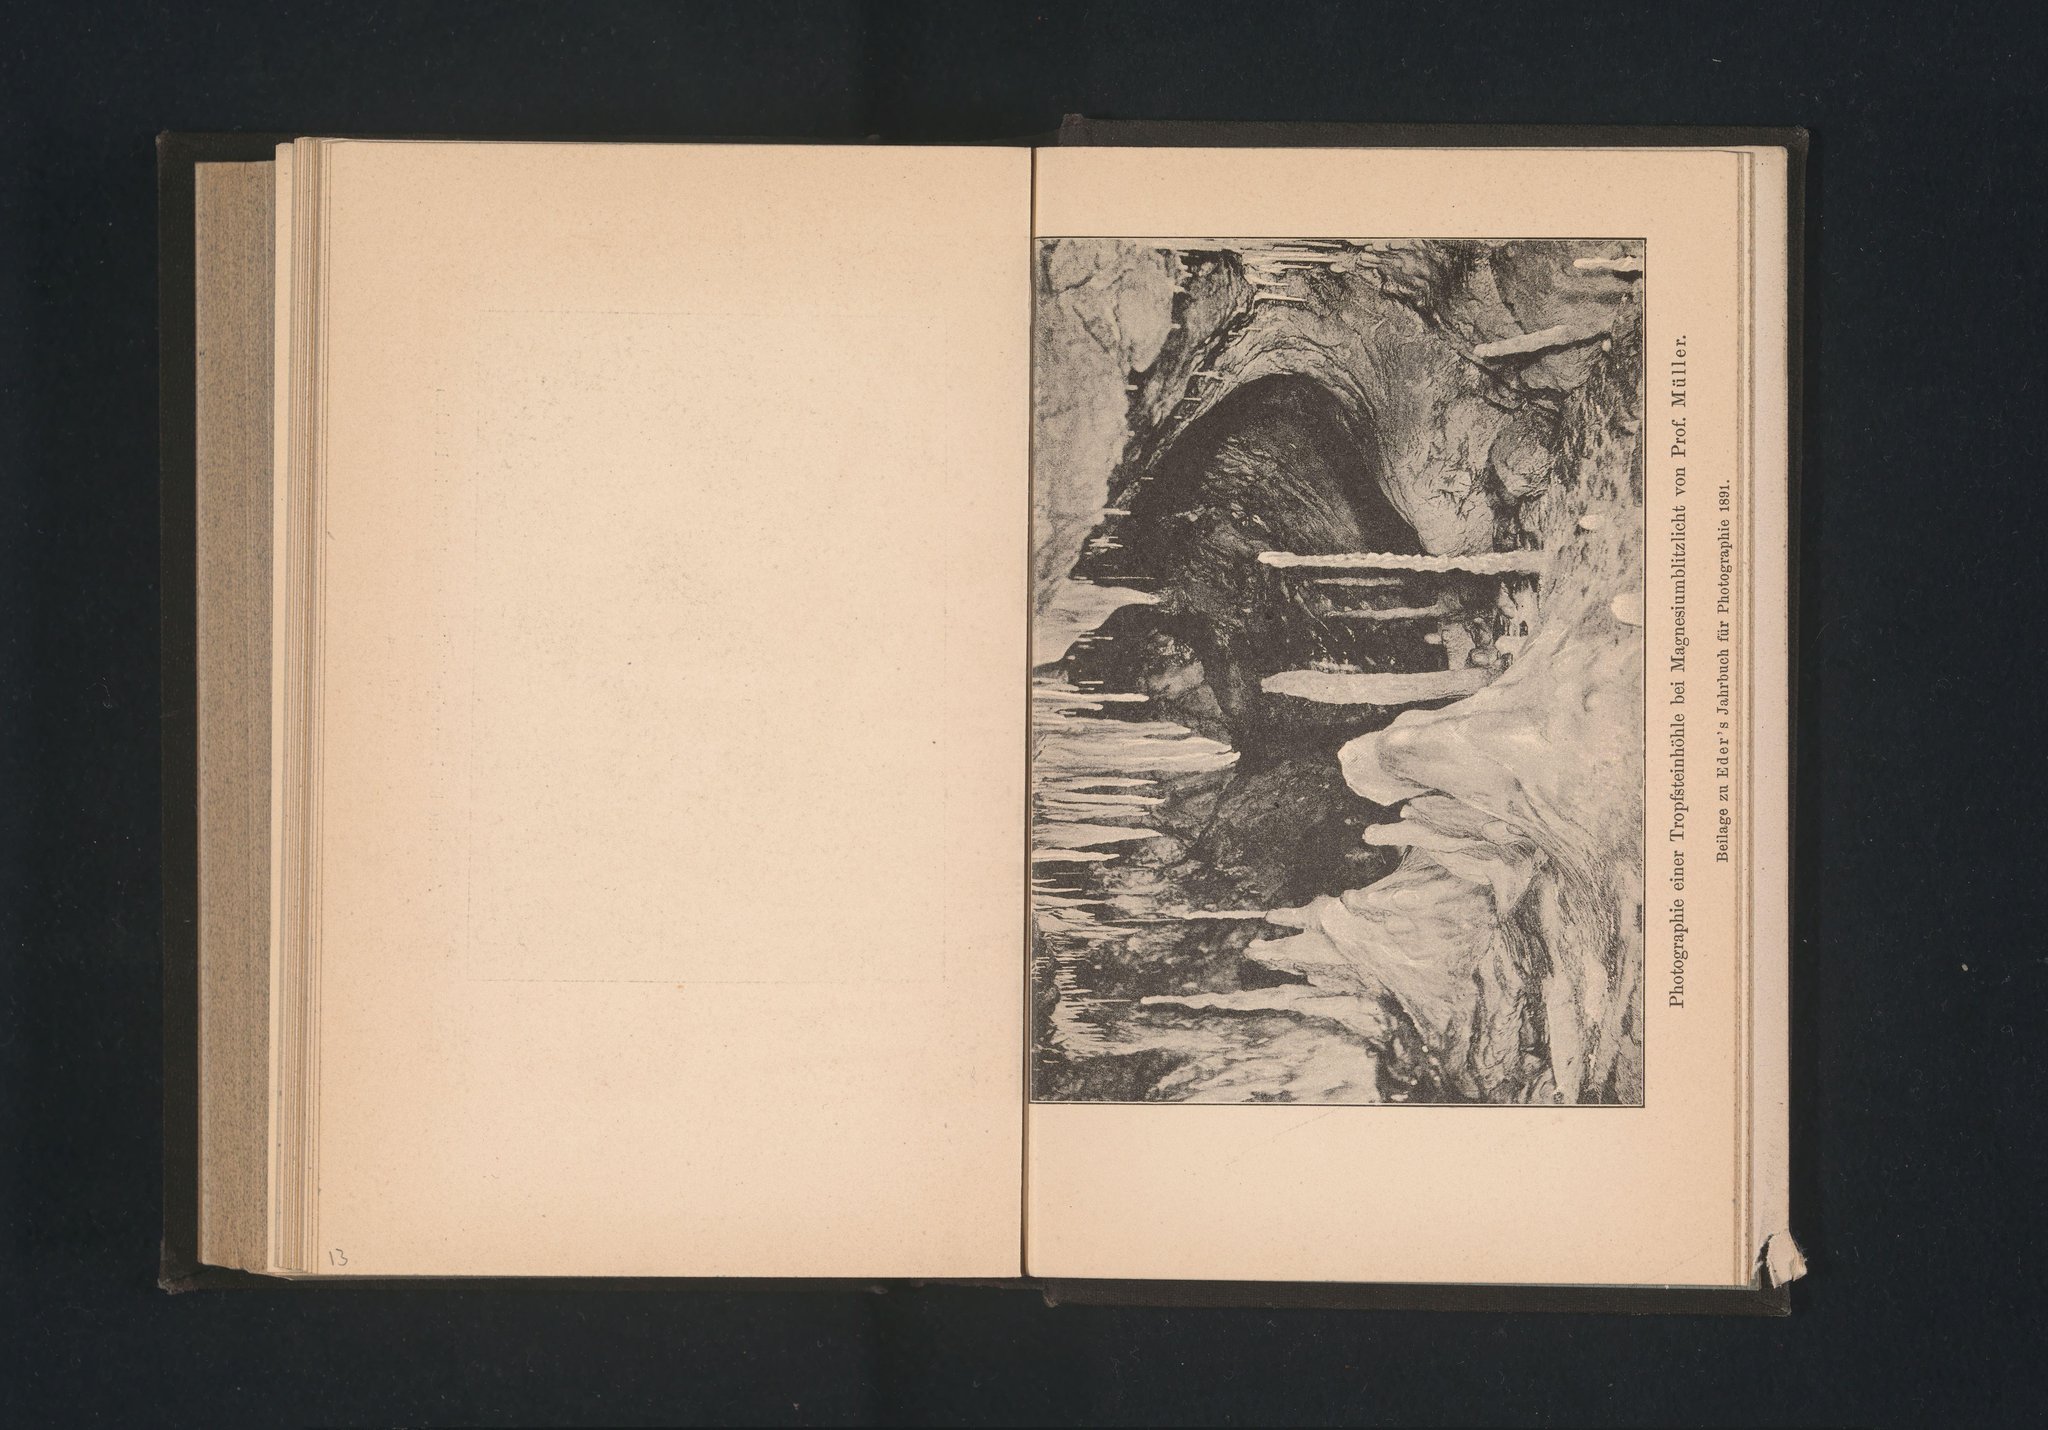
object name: page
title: Grot met stalagmieten en stalactieten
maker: Anonymous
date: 1886-1891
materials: paper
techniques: autotype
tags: stalactitic cave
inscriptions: inscription: ‘Photographie einer Tropfsteinhöhle bei Magnesiumblitzlicht von Prof. Müller/ Beilage zu Eder's Jahbruch für Photographie 1891’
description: Prent op zesendertigste ongenummerde pagina na pagina 627.